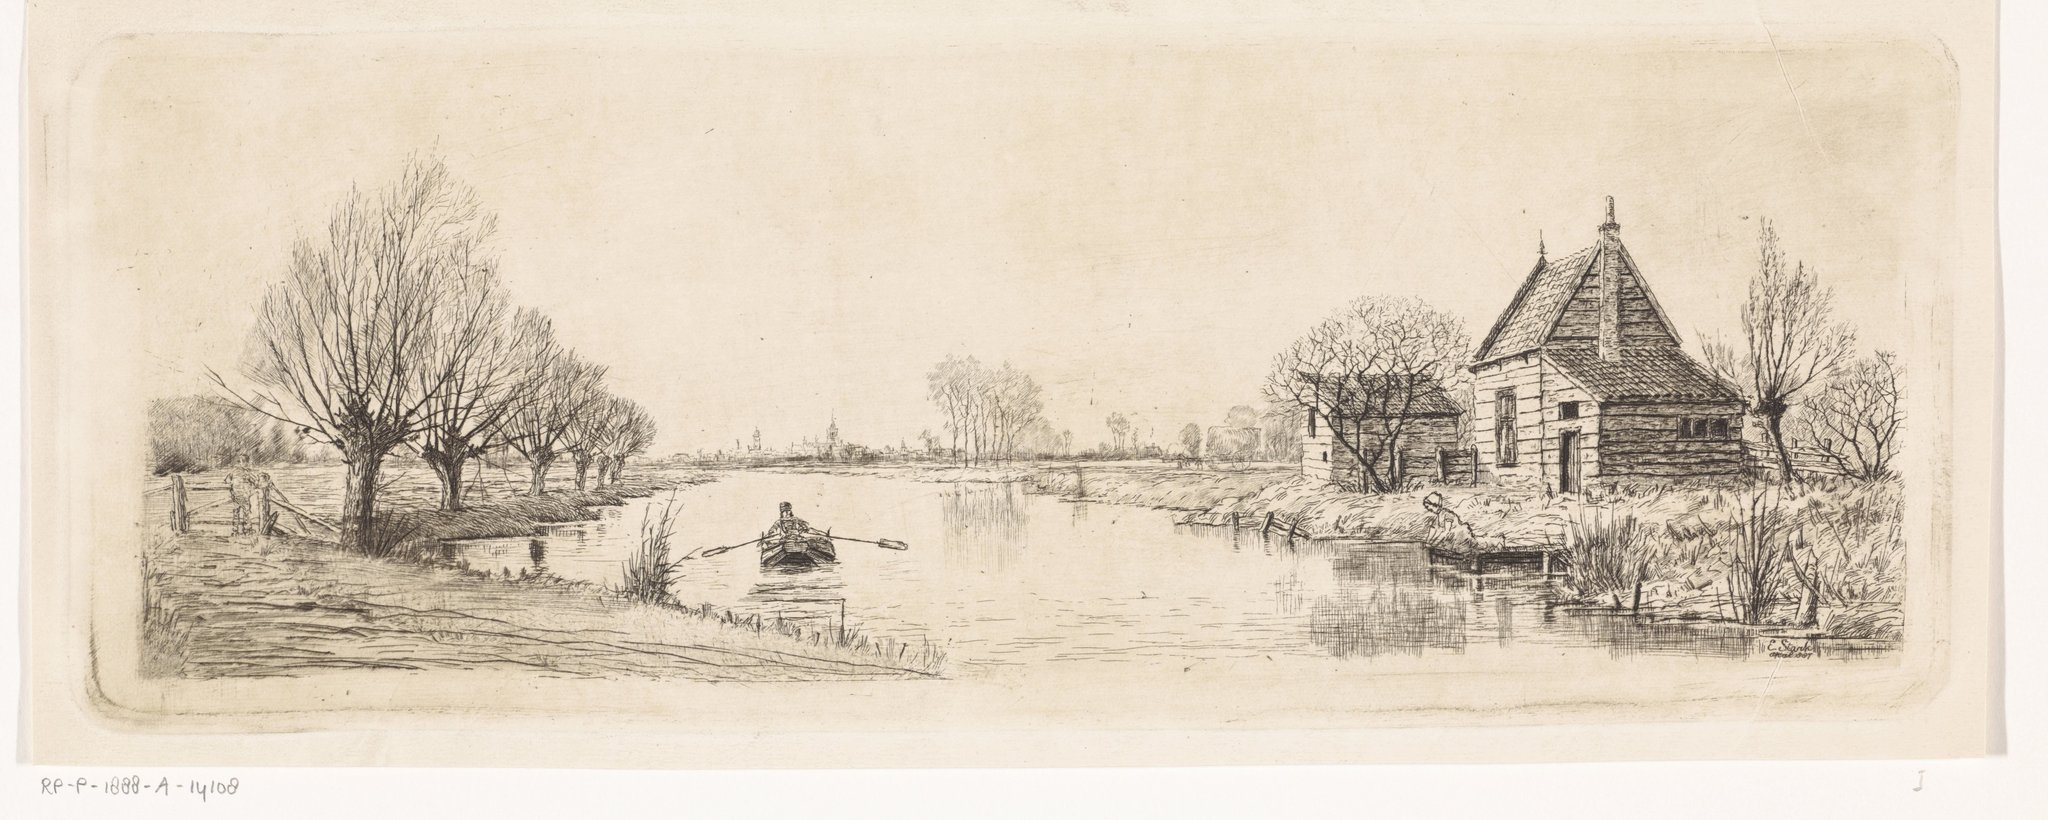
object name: print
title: Rivierlandschap met een houten woning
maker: elias stark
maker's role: draughtsman, print maker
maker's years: 1849-1933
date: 1804-1887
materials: paper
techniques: etching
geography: nieuwer-amstel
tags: river, rowing-boat, canoe, etc., farm or solitary house in landscape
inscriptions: collector's mark: Lugt 2228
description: Op een rivier vaart een man in een roeiboot. Rechts op de oever staat een houten en huis. Een vrouw knielt op de steiger.